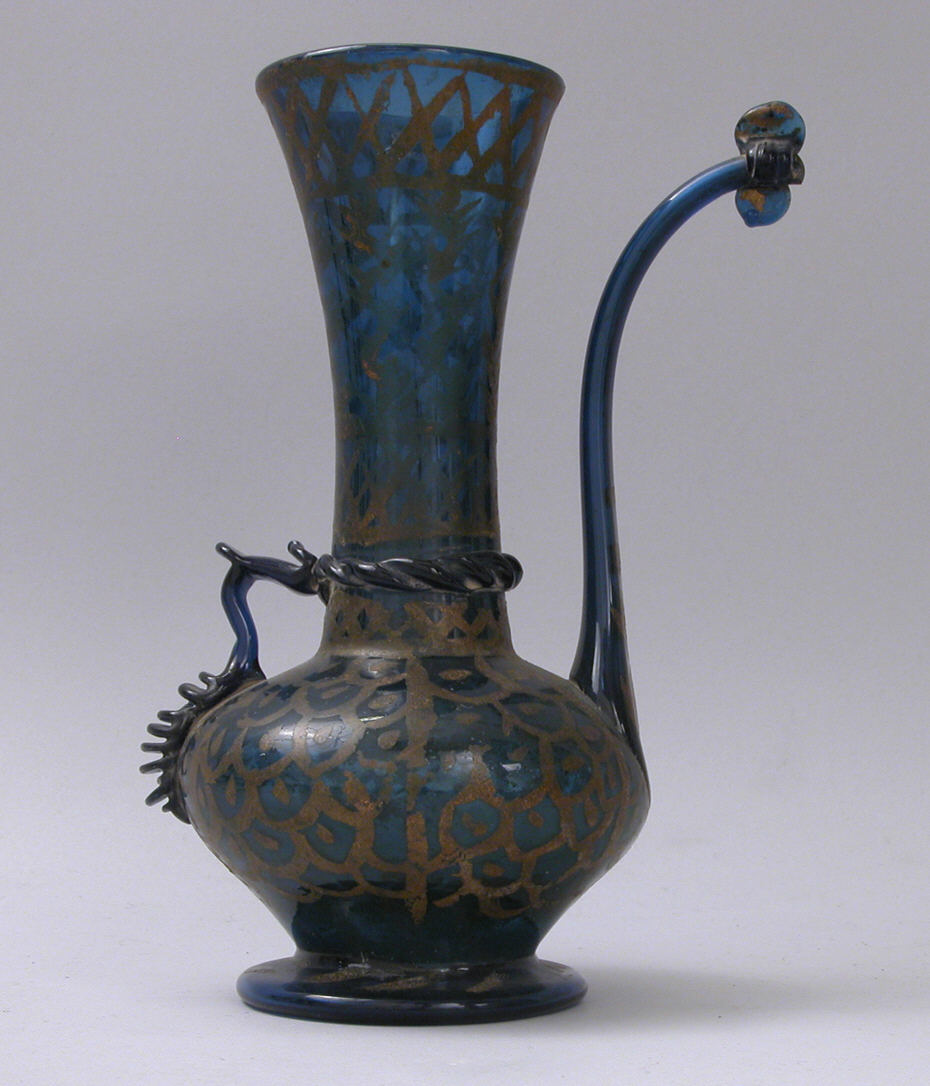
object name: ewer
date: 1701-1900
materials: glass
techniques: glassblowing, painting, tooling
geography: iran